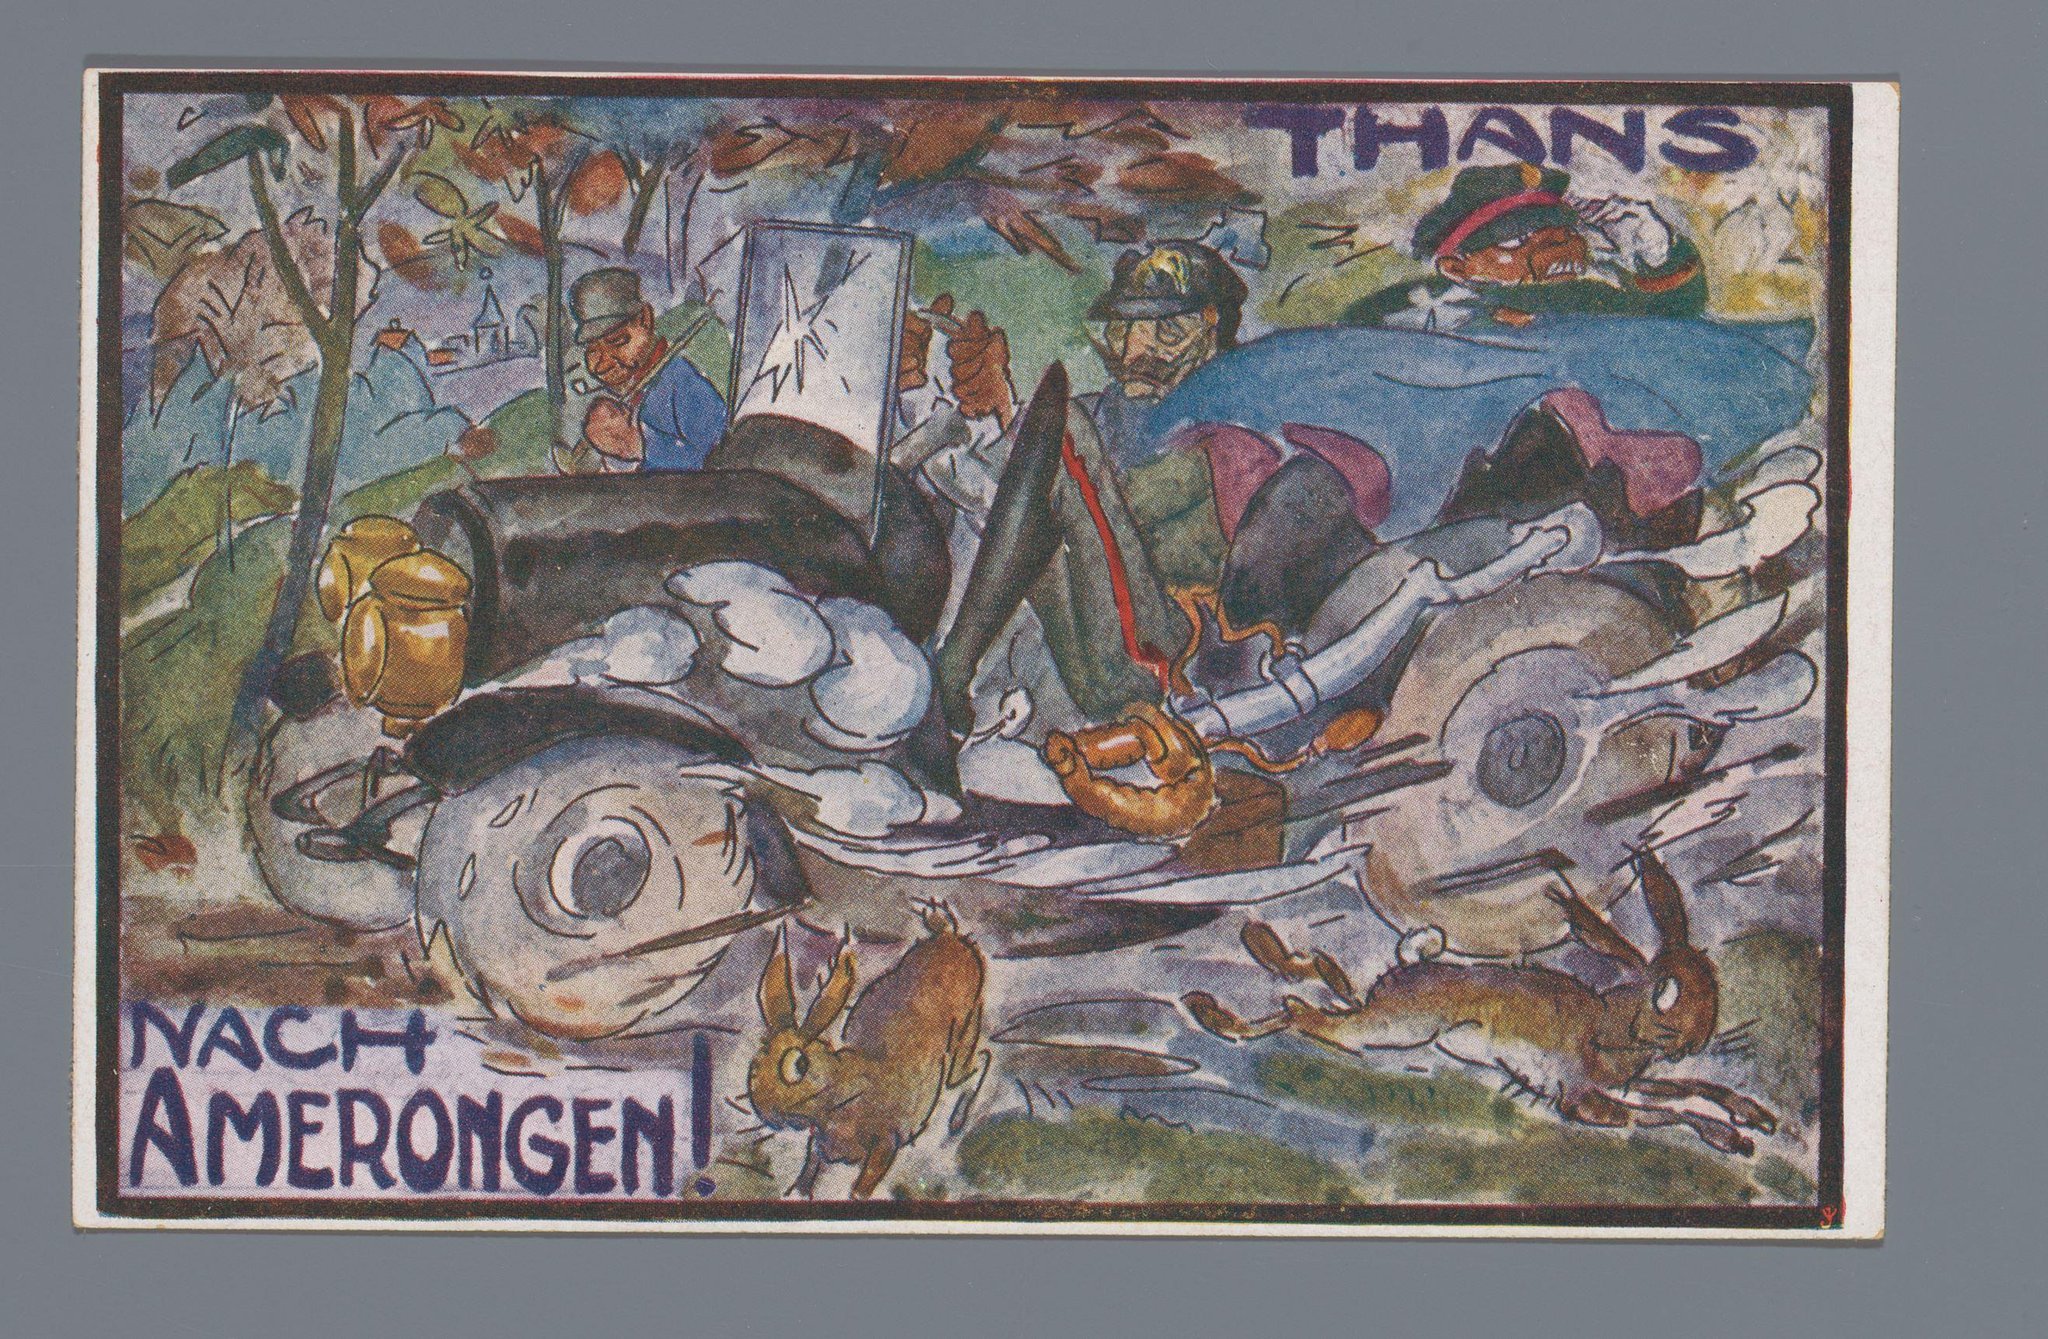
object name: postcard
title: Thans, Nach Amerongen!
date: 1919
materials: paper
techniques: printing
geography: bussum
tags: wilhelm ii (keizer van duitsland), automobile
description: Briefkaart omtrent de Eerste Wereldoorlog. In bos, centraal: op een auto waarin man (keizer Wilhelm II) in uniform met cape. Op voorgrond twee konijnen. Linksachter: boer en dorpje. Rechtsachter: saluerende man in uniform.